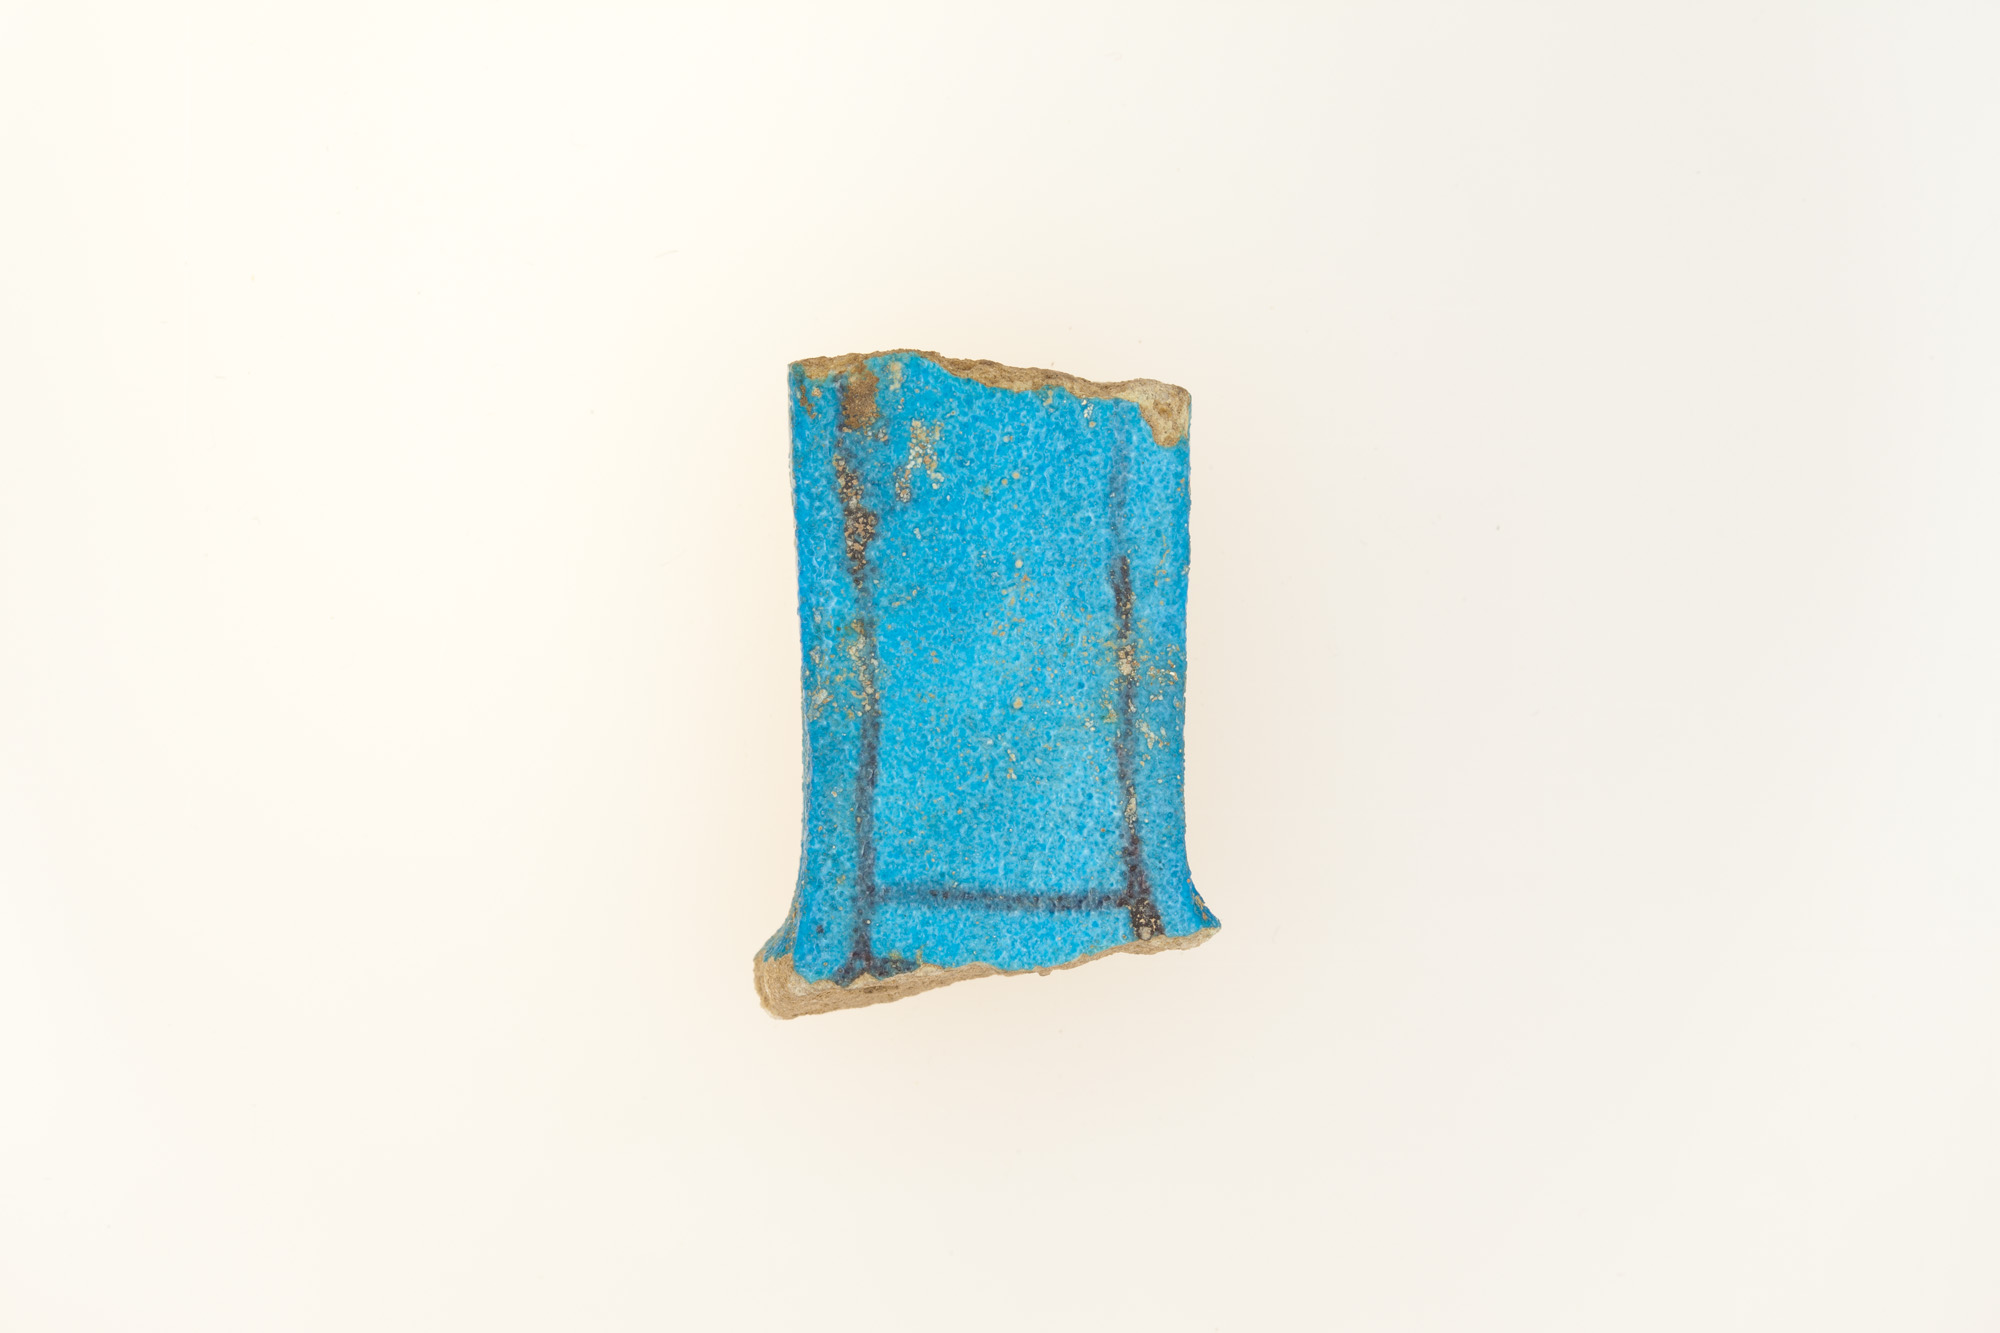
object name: menat fragment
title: Votive Menat fragments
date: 1479-1458 BCE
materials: faience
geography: egypt